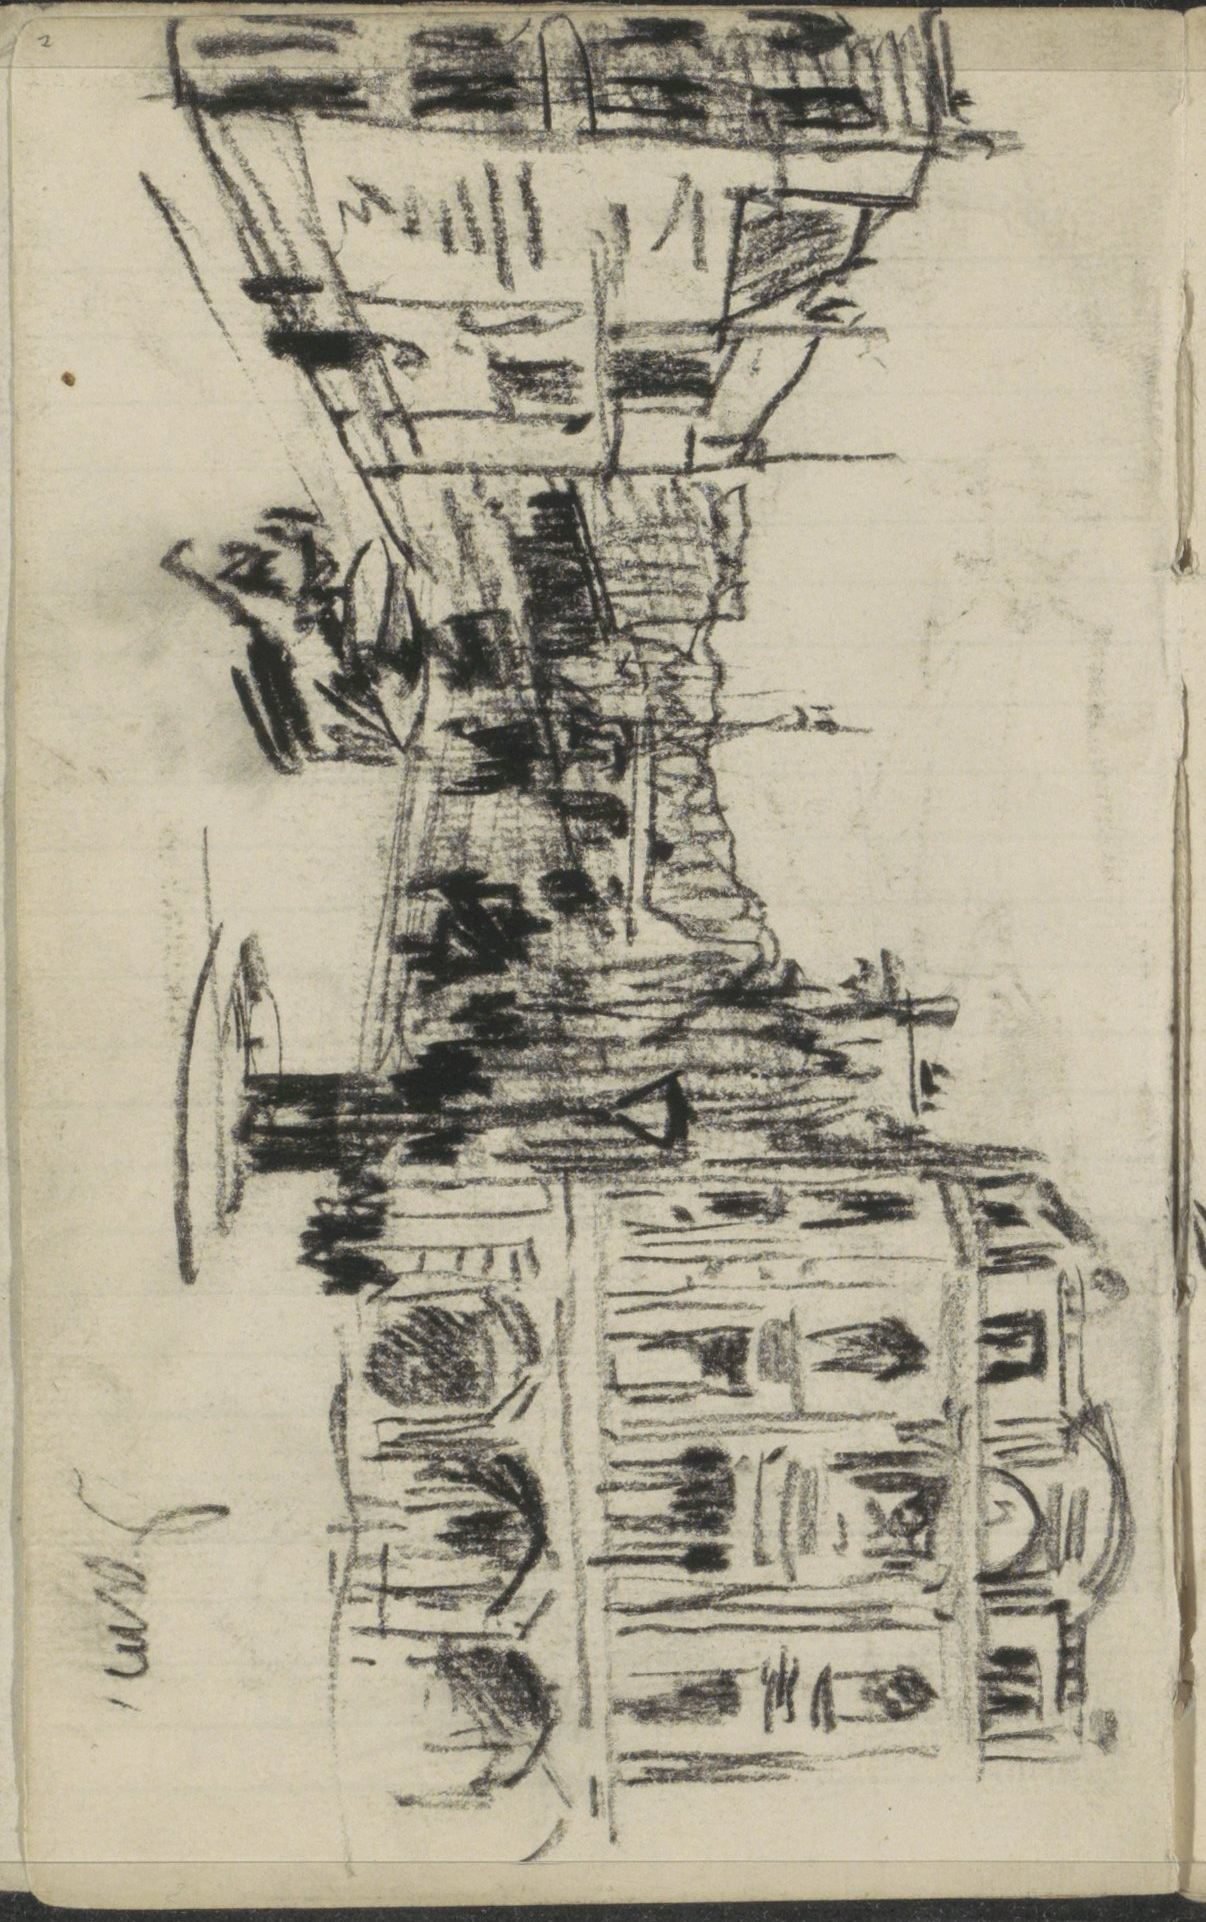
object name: sketchbook leaf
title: Dam te Amsterdam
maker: marius bauer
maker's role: draughtsman, print maker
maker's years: 1867-1932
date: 1881-1885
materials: chalk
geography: amsterdam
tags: square, place, circus, etc.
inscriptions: annotation: ‘Dam.’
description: Pagina 2 uit een schetsboek met 26 bladen.